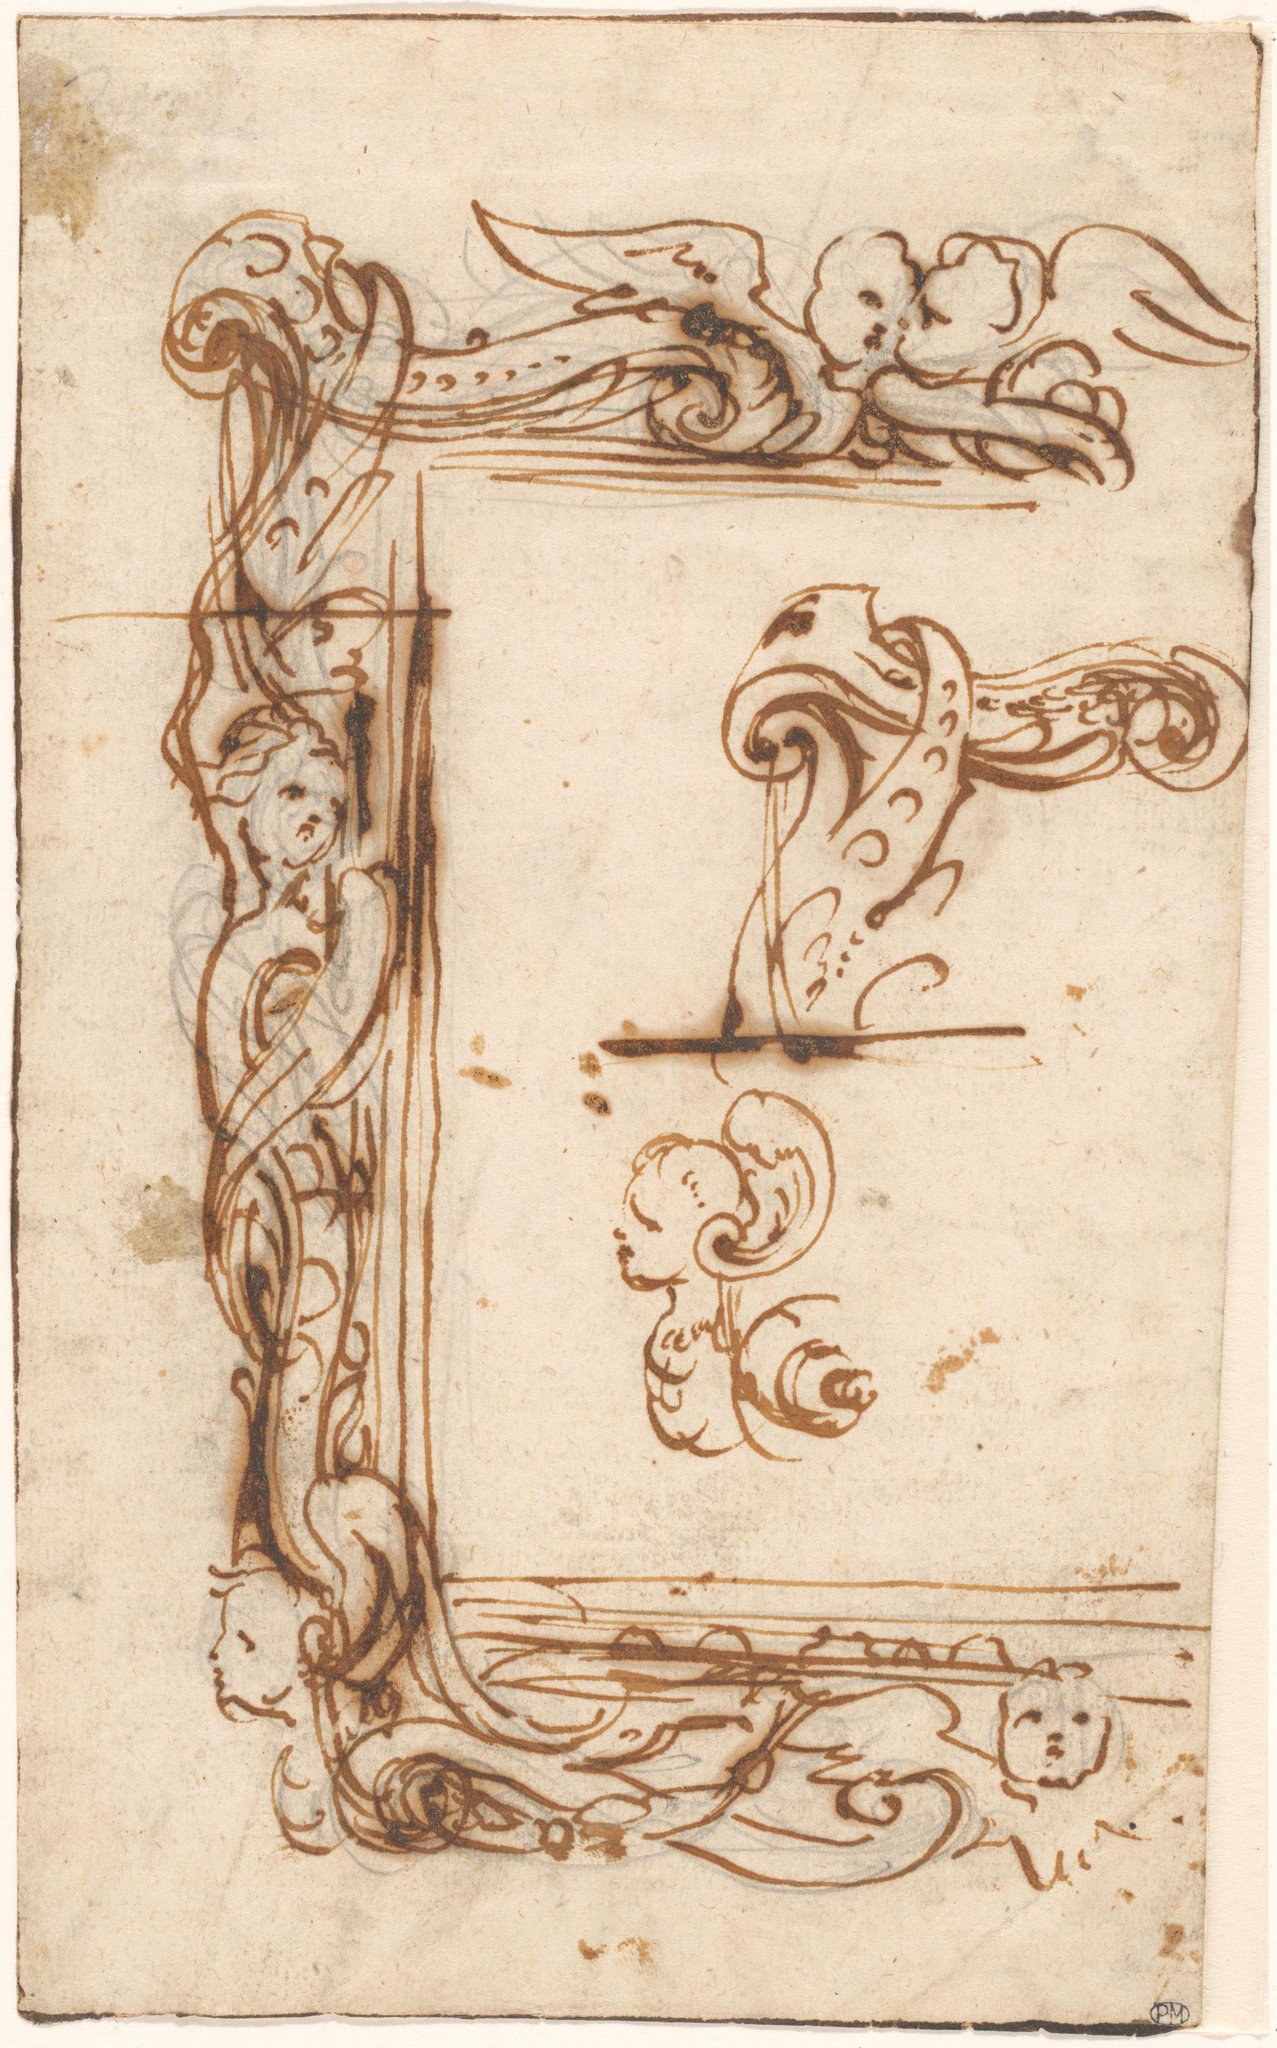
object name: drawing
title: Ontwerp voor een lijst, met een verbeterde oplossing voor de linker bovenhoek en de linker onderhoek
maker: Anonymous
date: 1610-1625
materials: graphite, ink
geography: florence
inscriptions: inscription: ‘verschillende getallen’, watermark: ‘D’, collector's mark: ‘PM’, stamp: ‘Alexandre UJAKY / ANTIQUAIRE / 4, RUE DROUOT, PARIS […] / TÉL. PRO. 66-14 / R.C. SEINE 224.240’, inscription: ‘G.P. Schot’